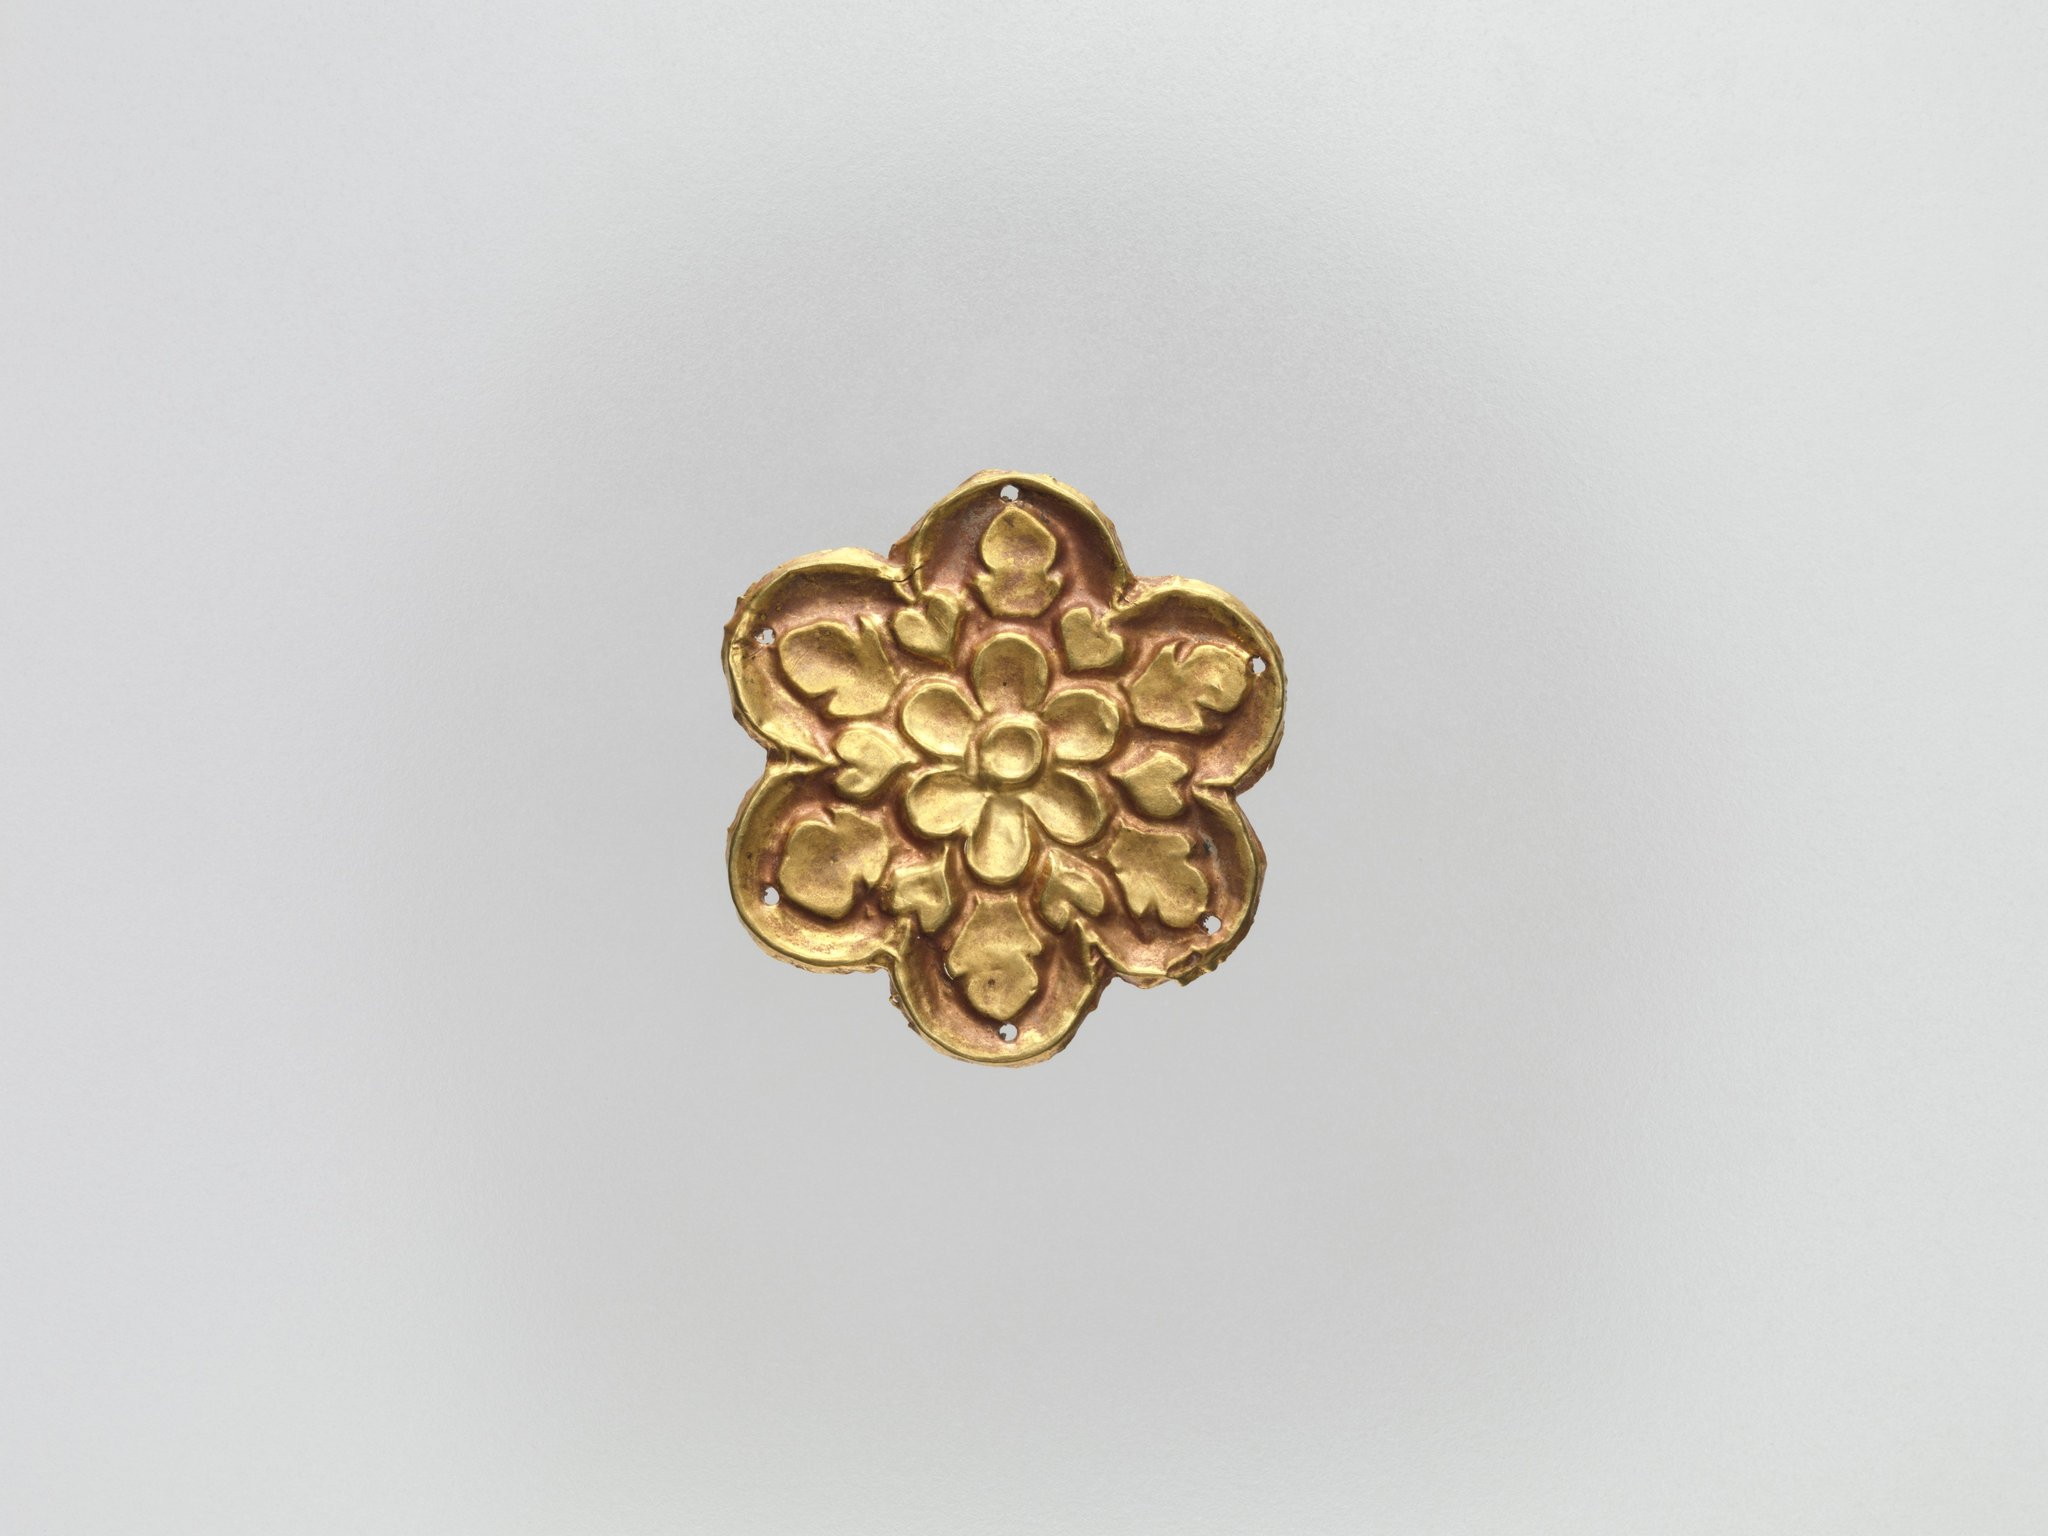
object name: garment plaque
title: Flower-Shaped Clothing Plaque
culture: chinese or central asian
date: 601-900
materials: gold